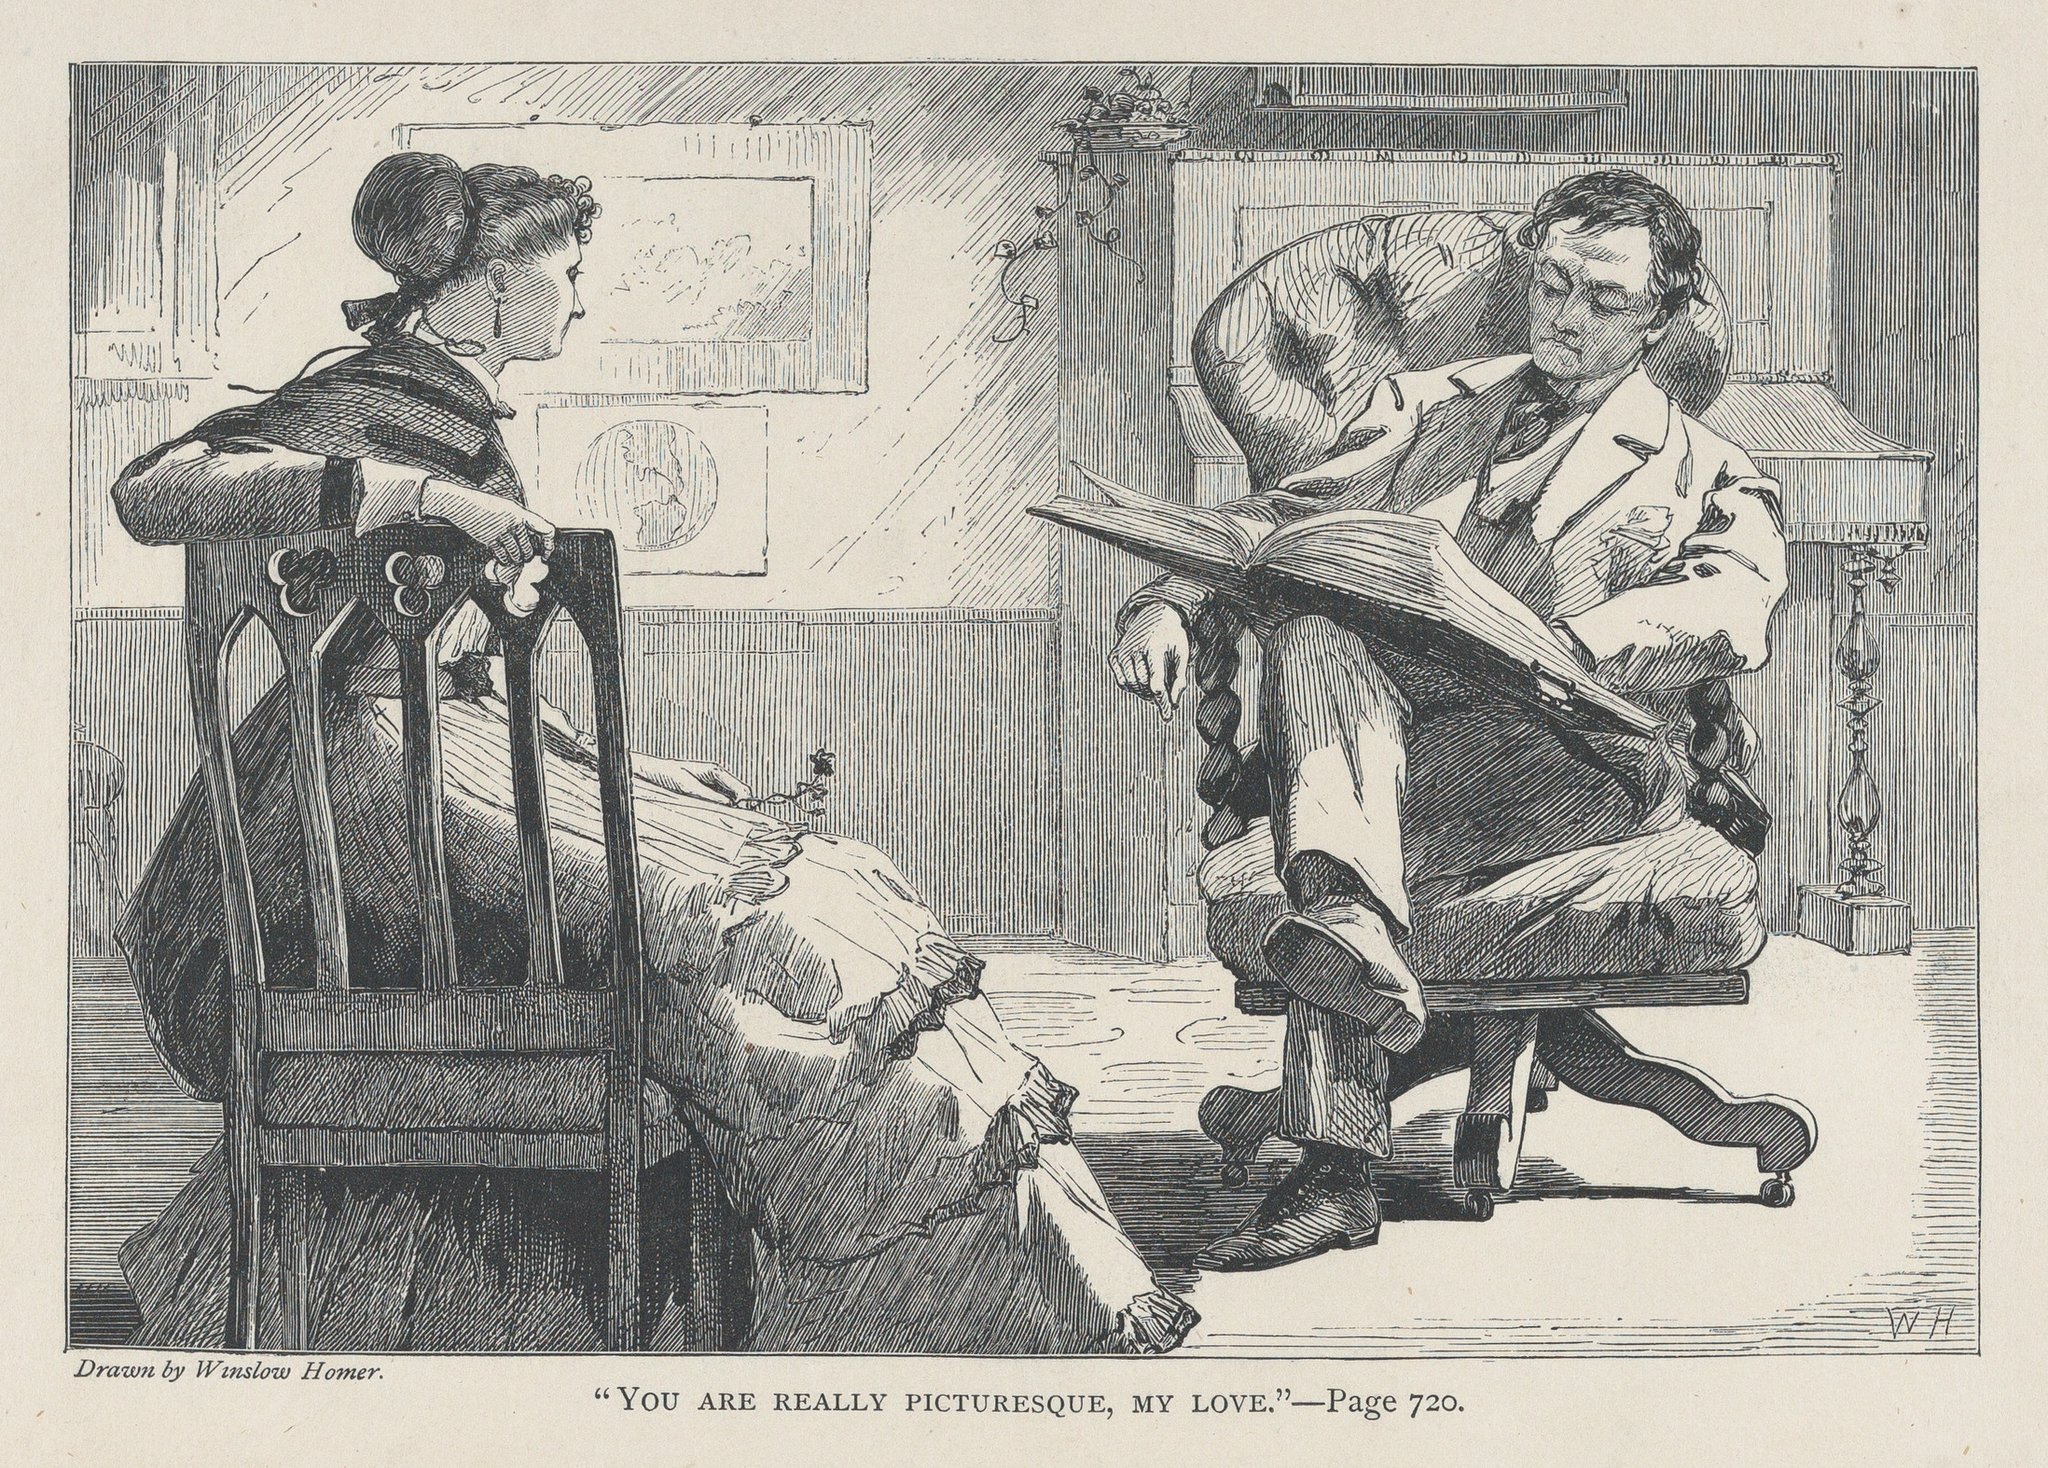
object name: print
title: "You Are Really Picturesque, My Love" (The Galaxy, An Illustrated Magazine of Entertaining Reading, Vol. V)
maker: winslow homer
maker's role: artist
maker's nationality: american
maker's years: 1836-1910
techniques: engraving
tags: men,women,reading